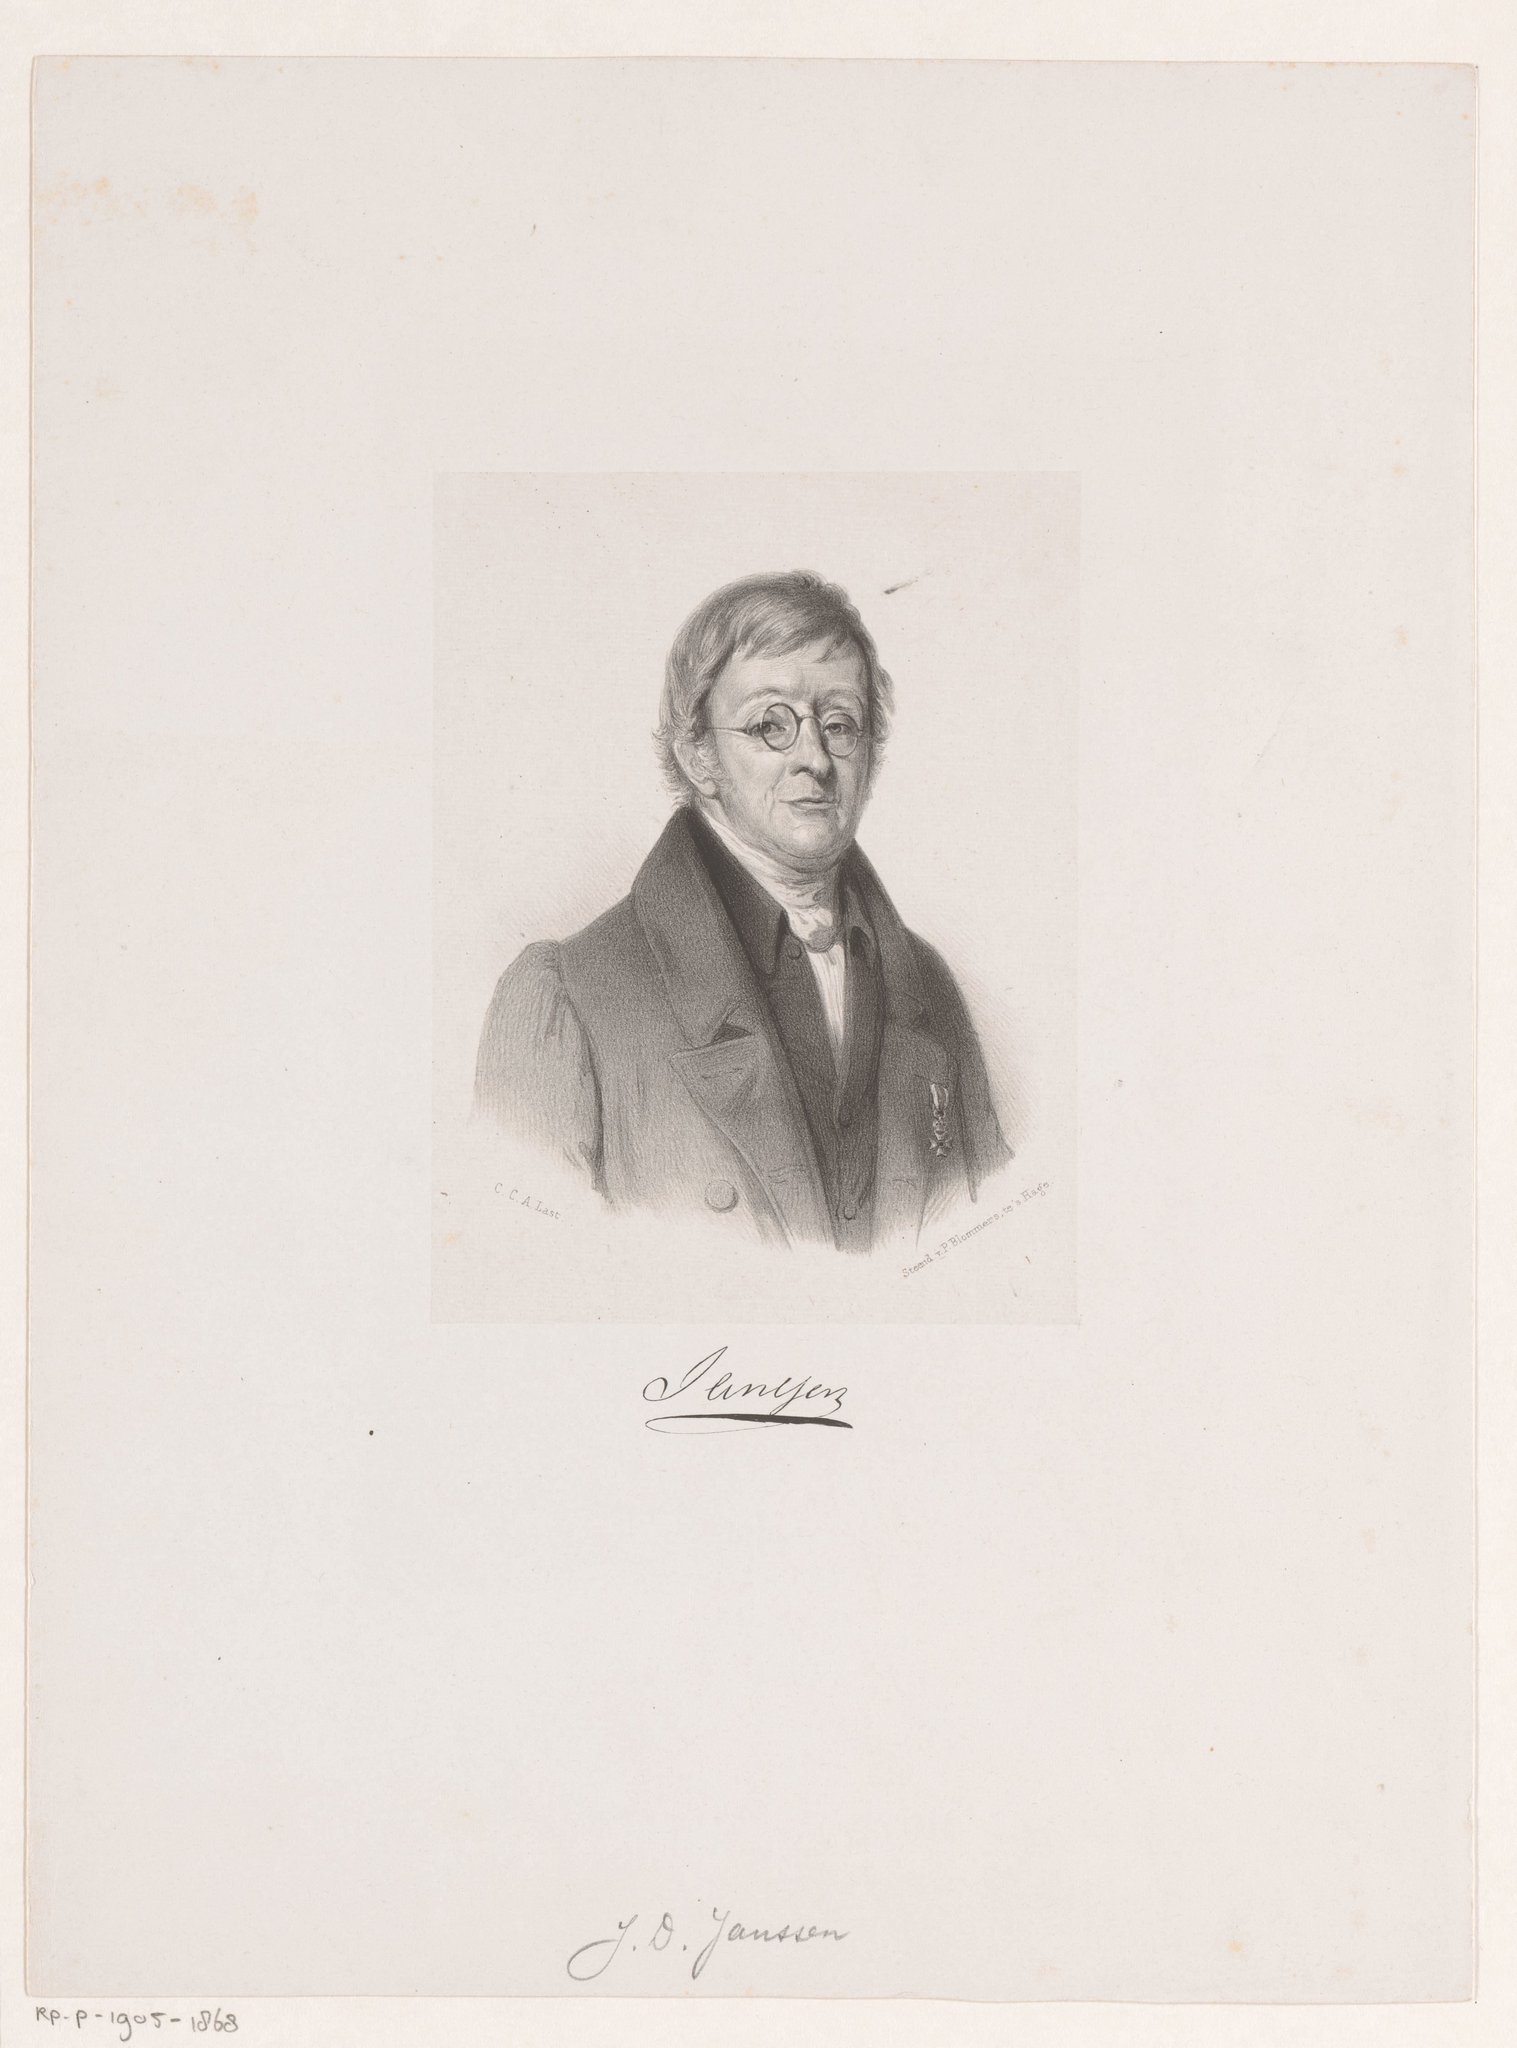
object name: print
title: Portret van Jacobus Didericus Janssen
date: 1855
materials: paper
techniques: lithograph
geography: the hague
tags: the hague, official, eyeglasses, spectacles, knighthood order, historical persons (+ (full) bust portrait)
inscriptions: collector's mark: Lugt 2228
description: De geportretteerde draagt een bril en een ridderorde op zijn jas. Onder het portret zijn signatuur.